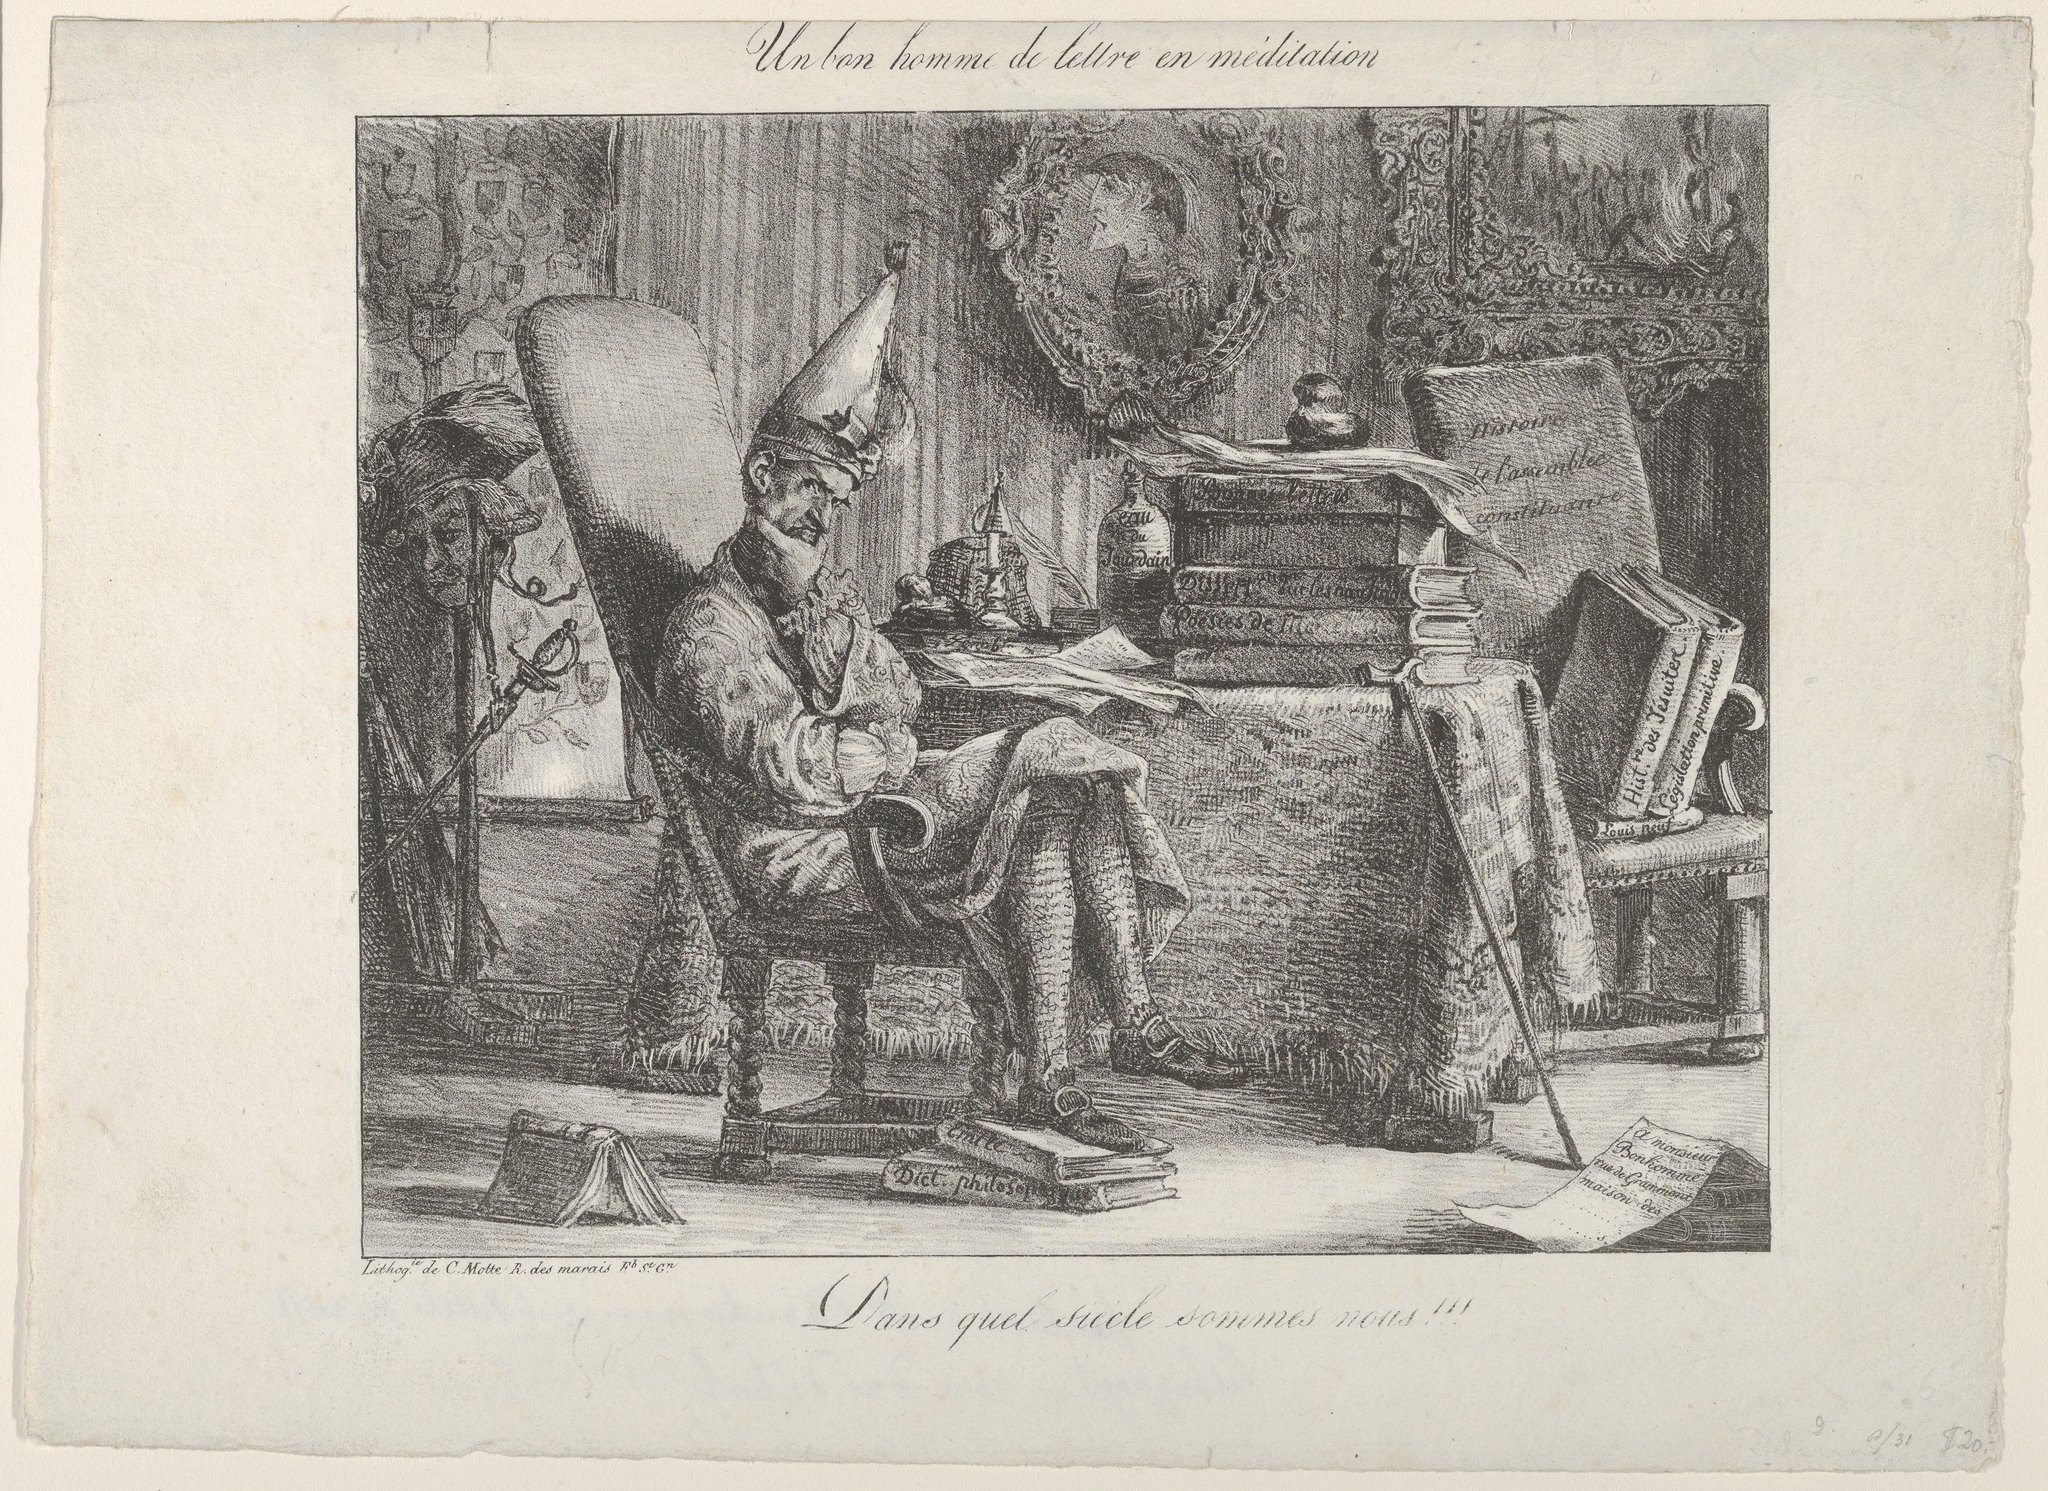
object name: print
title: A Literary Fellow Meditating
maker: Anonymous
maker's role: artist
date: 1821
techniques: lithograph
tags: books,contemplation,men